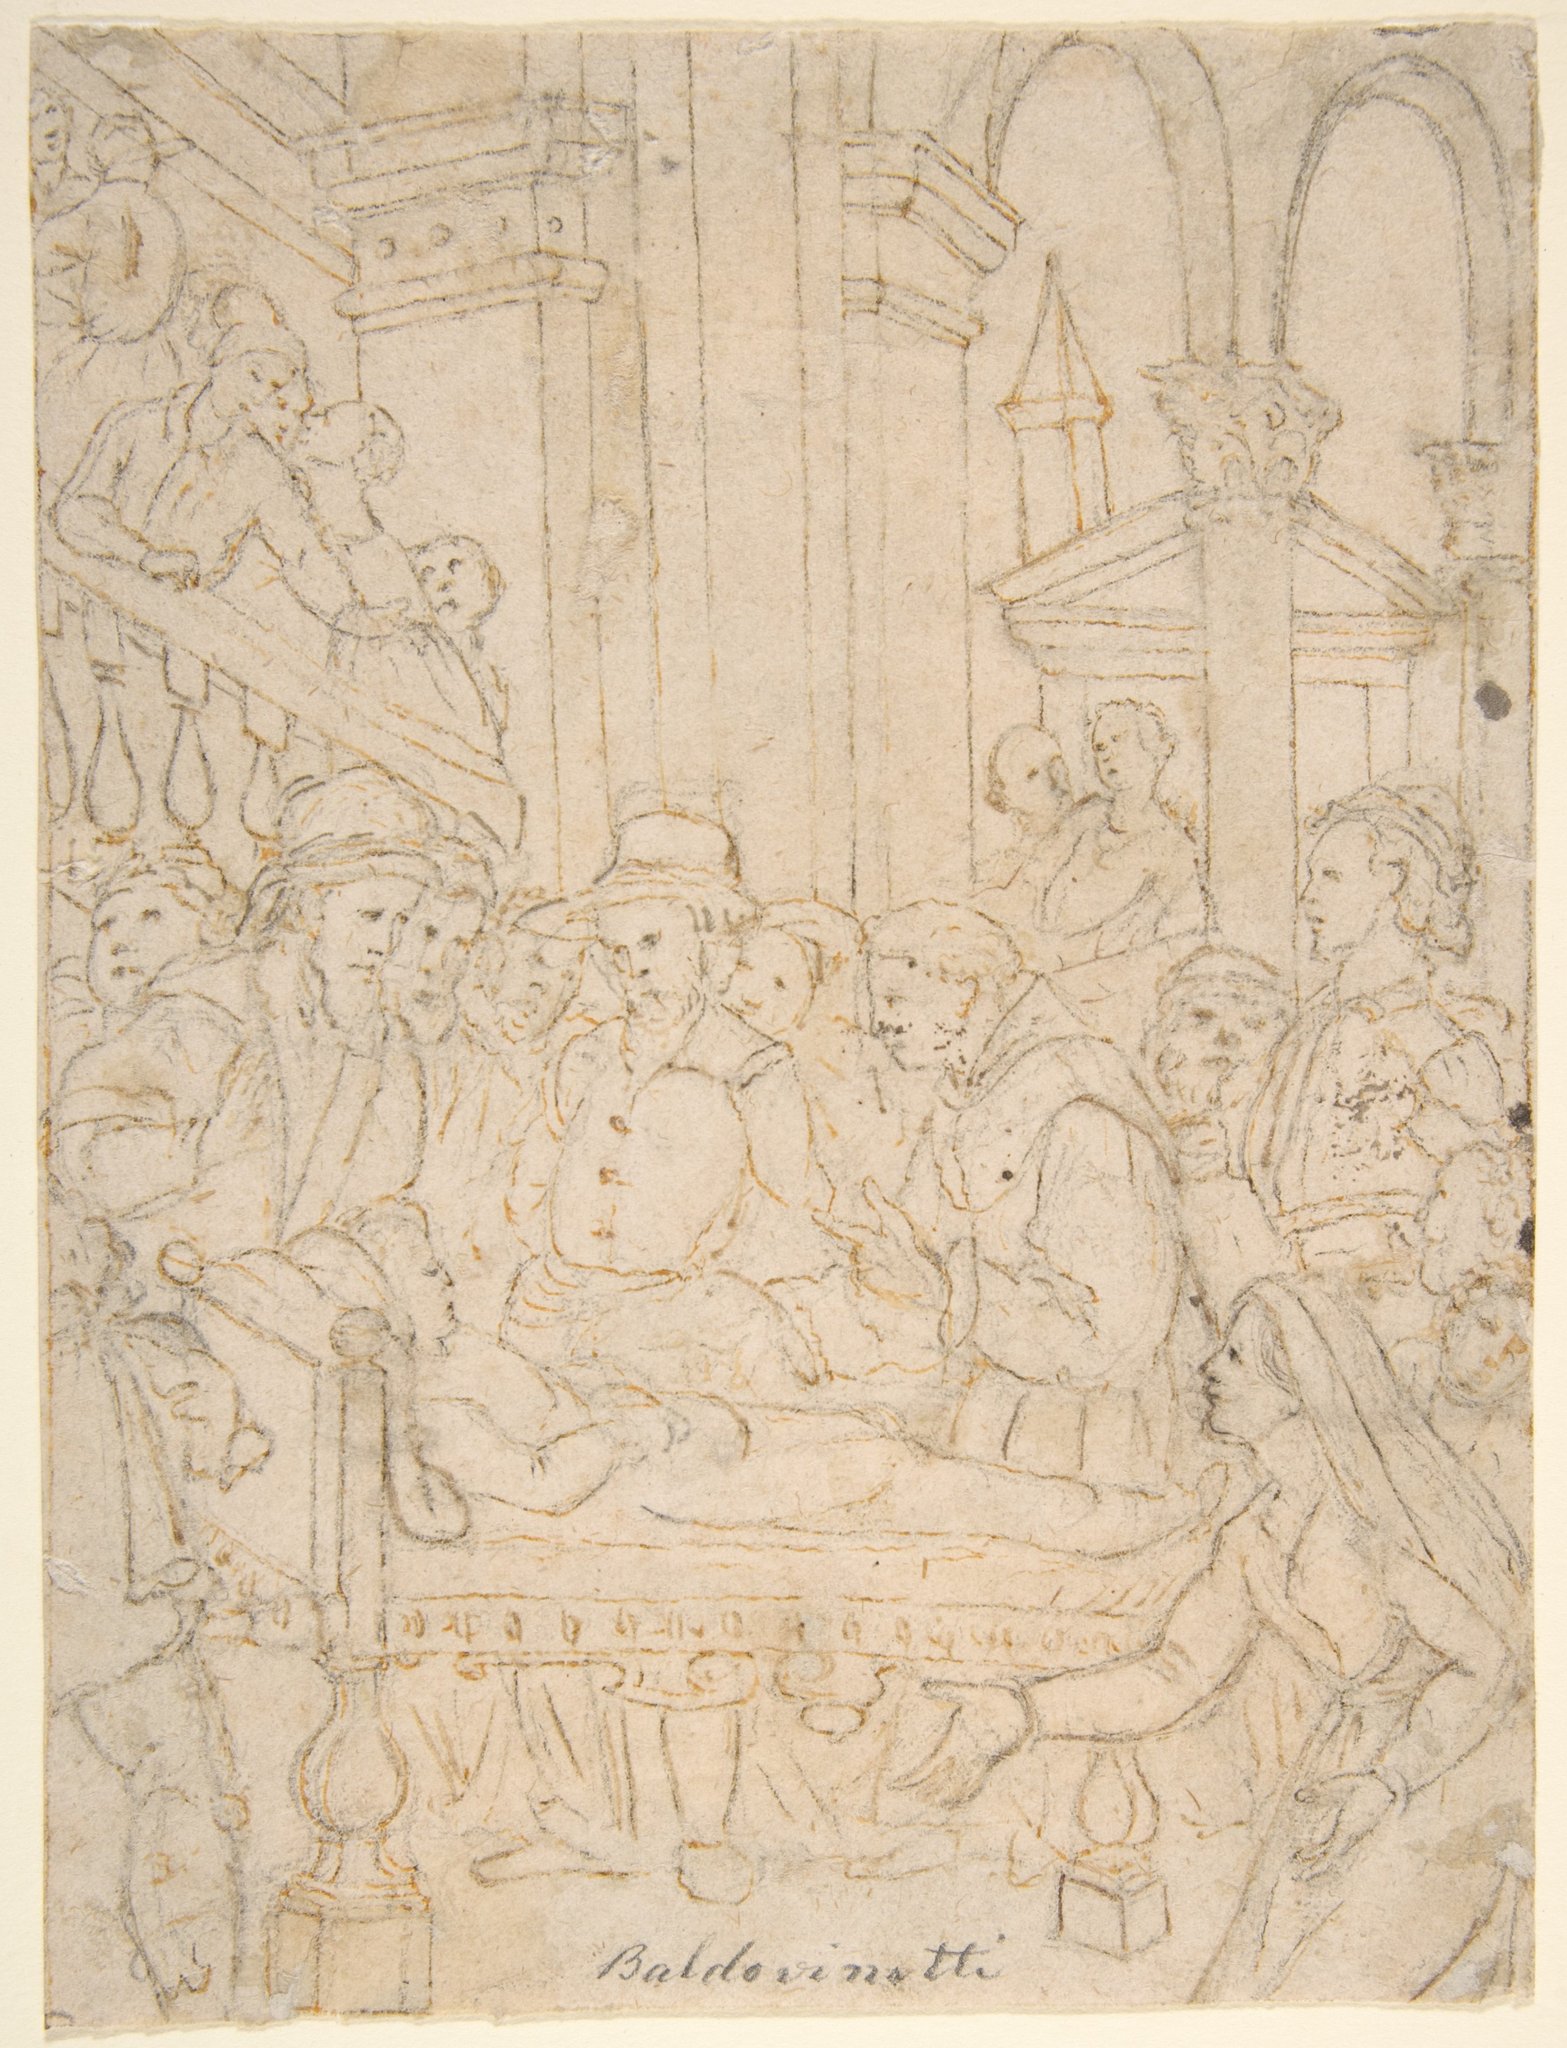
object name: drawing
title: Saint Anthony of Padua Healing a Sick Man (recto); Partial Figural Studies Based on the Composition on the Recto (verso)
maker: tiberio titi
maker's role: artist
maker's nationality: italian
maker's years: 1573-1622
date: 1590-1600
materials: chalk, ink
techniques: pen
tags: saint anthony,crowd